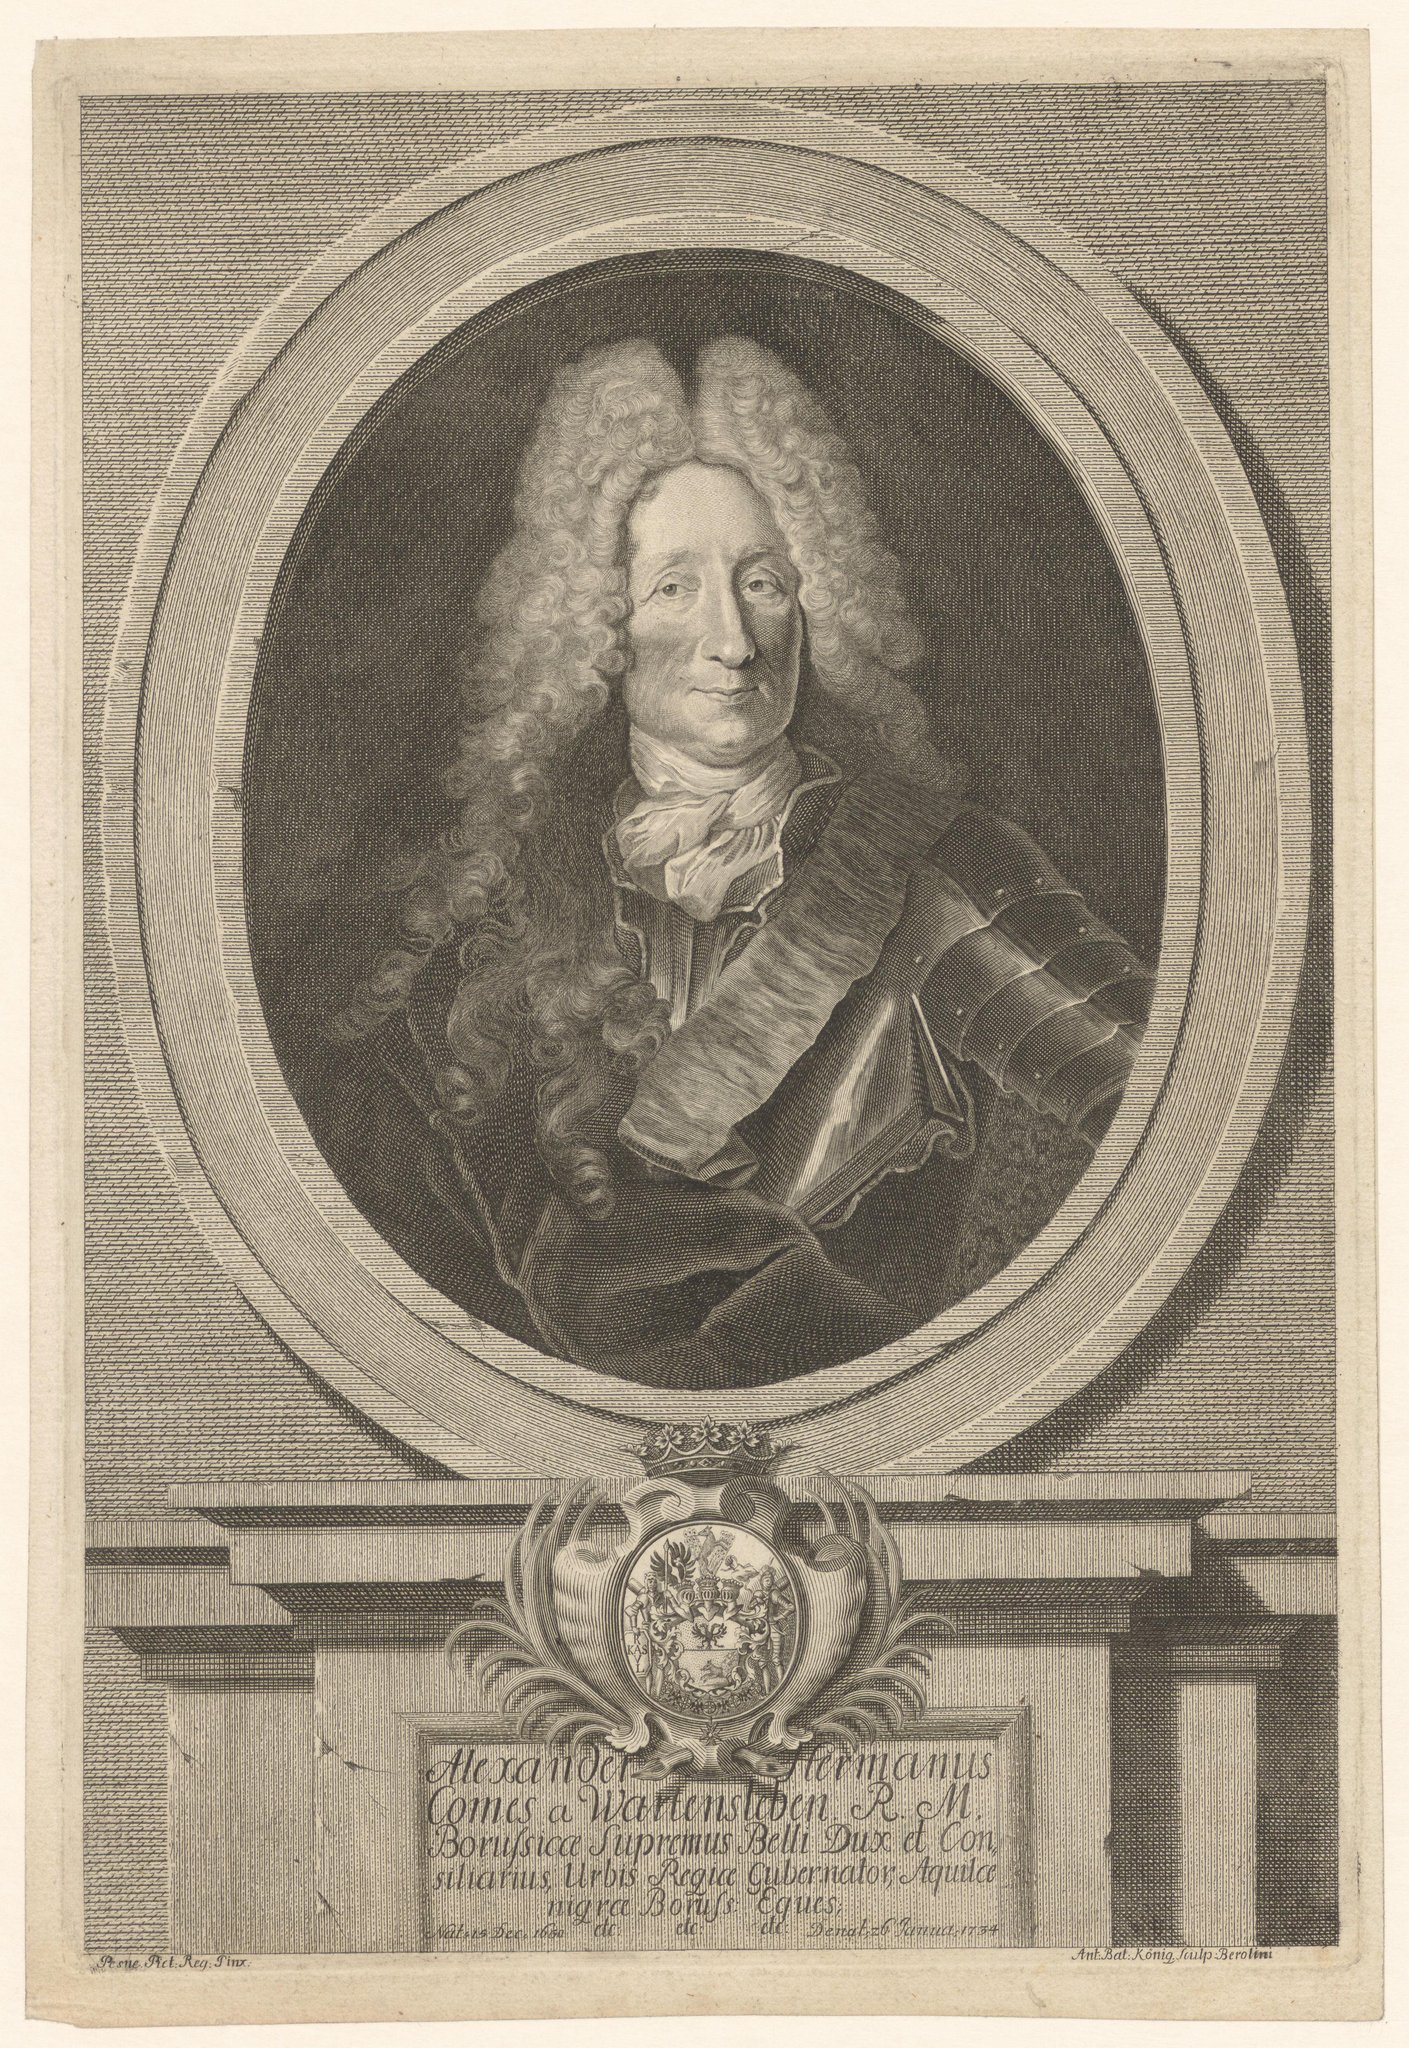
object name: print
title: Portret van Alexander Hermann von Wartensleben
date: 1734-1773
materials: paper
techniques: engraving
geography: berlin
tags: commander-in-chief, general, marshal, historical persons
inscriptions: collector's mark: Lugt 2228